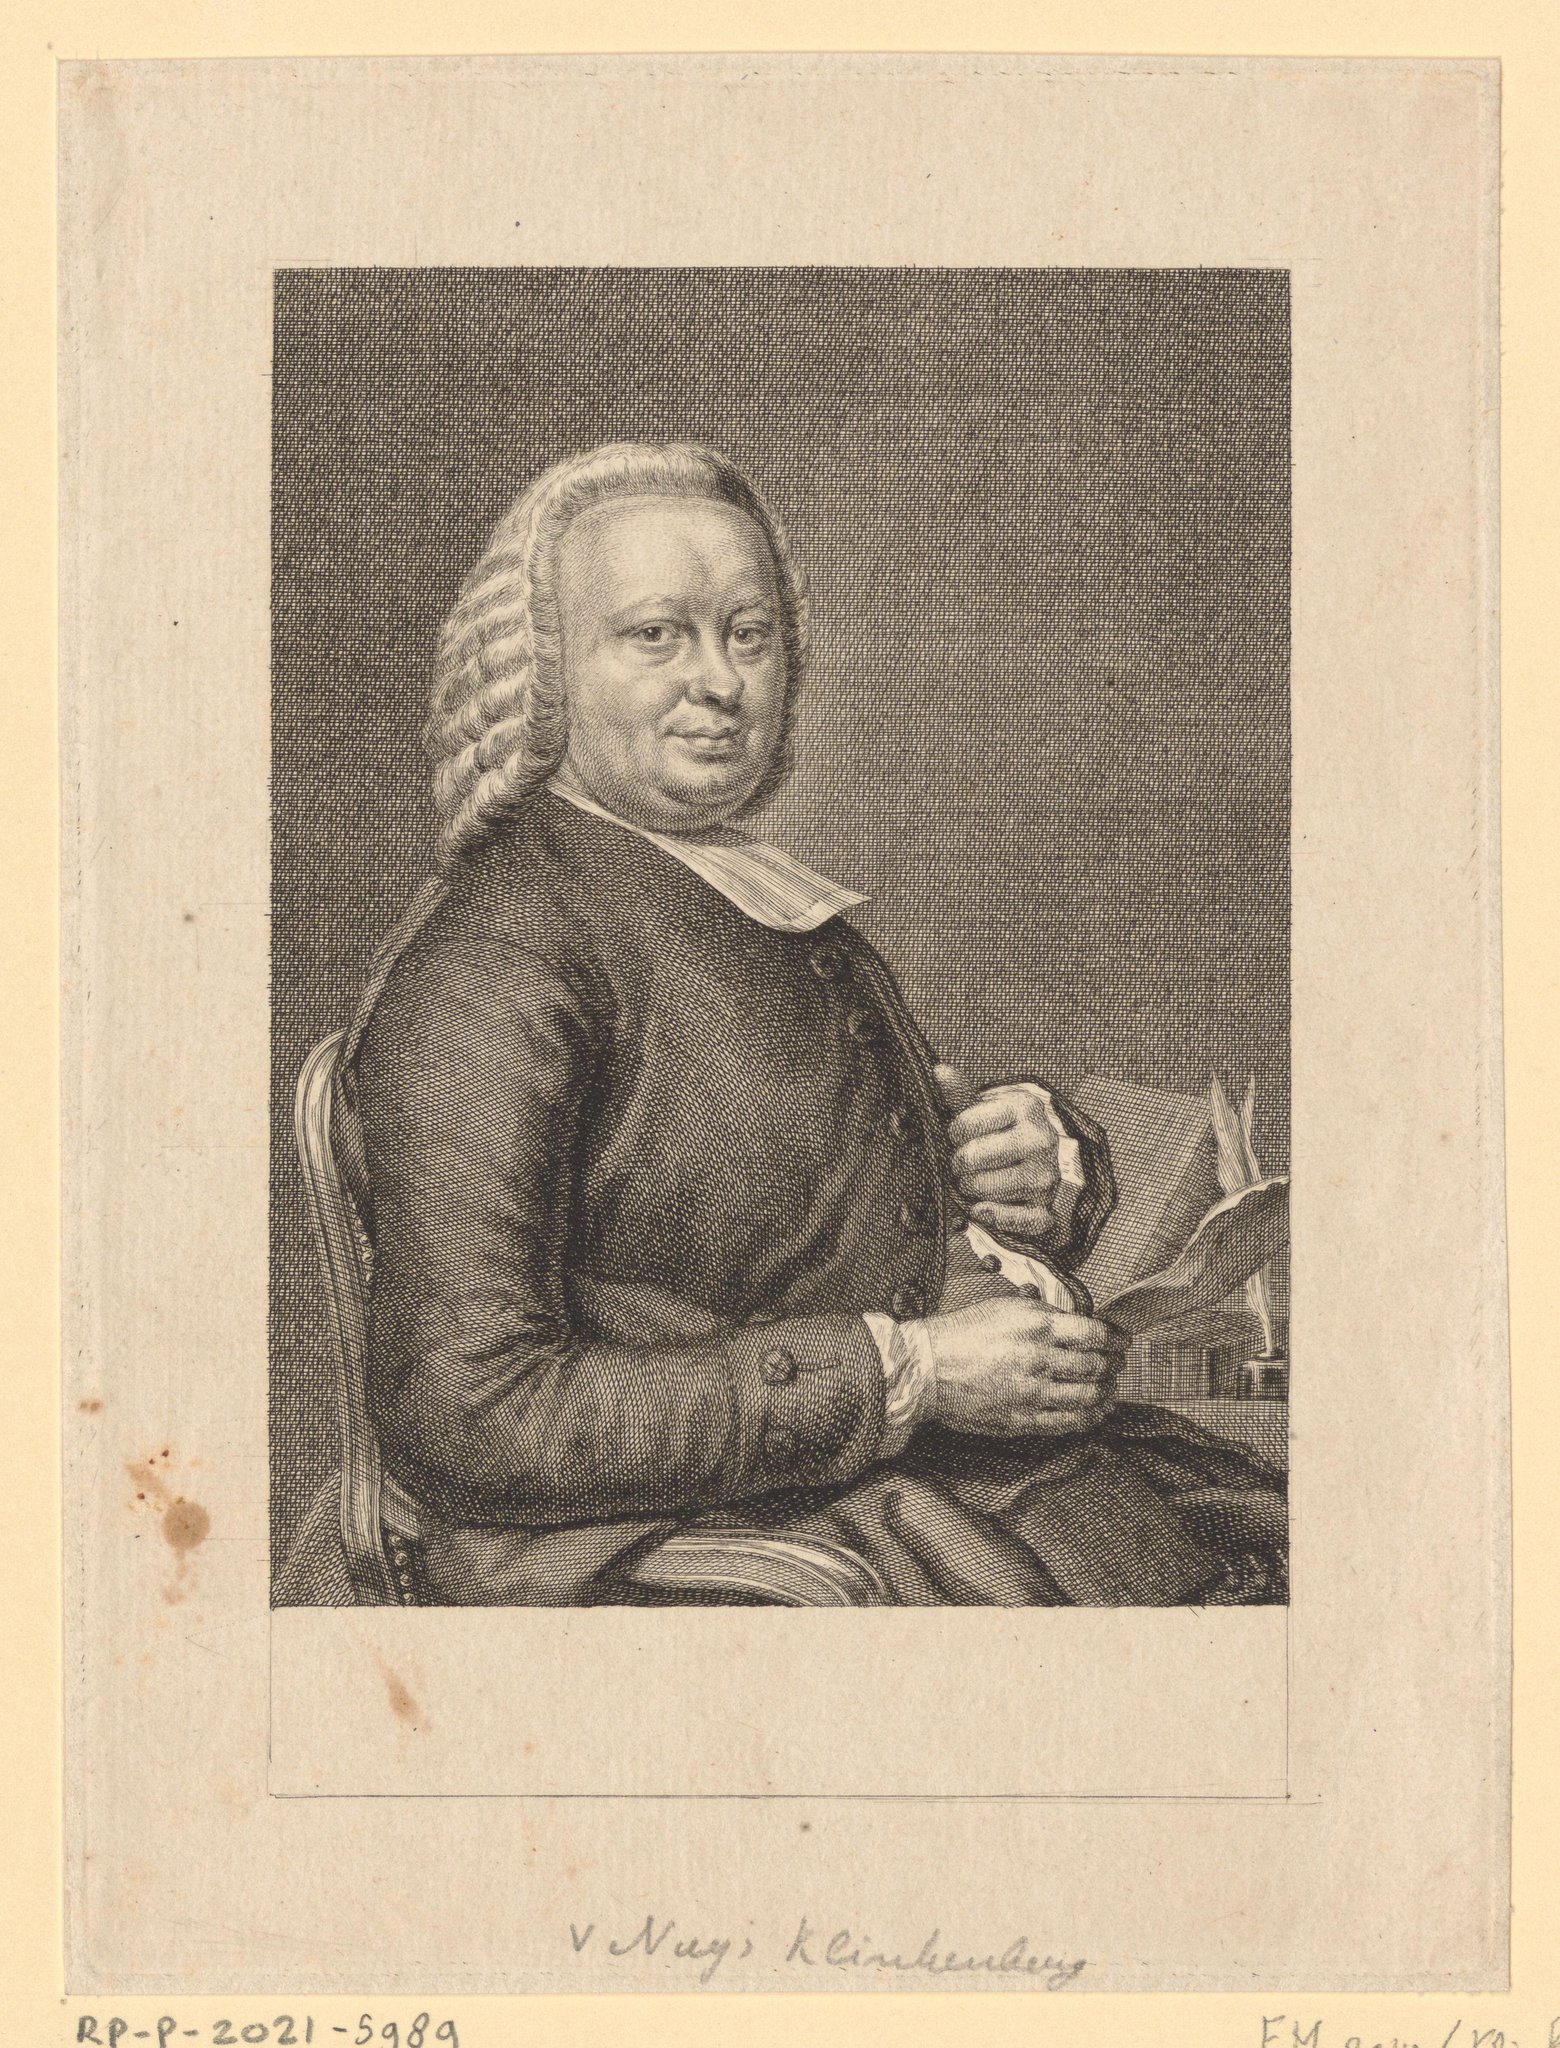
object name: print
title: Portret van Jacob van Nuys Klinkenberg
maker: jacob houbraken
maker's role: draughtsman, print maker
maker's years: 1698-1780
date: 1780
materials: paper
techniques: engraving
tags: historical persons, professor